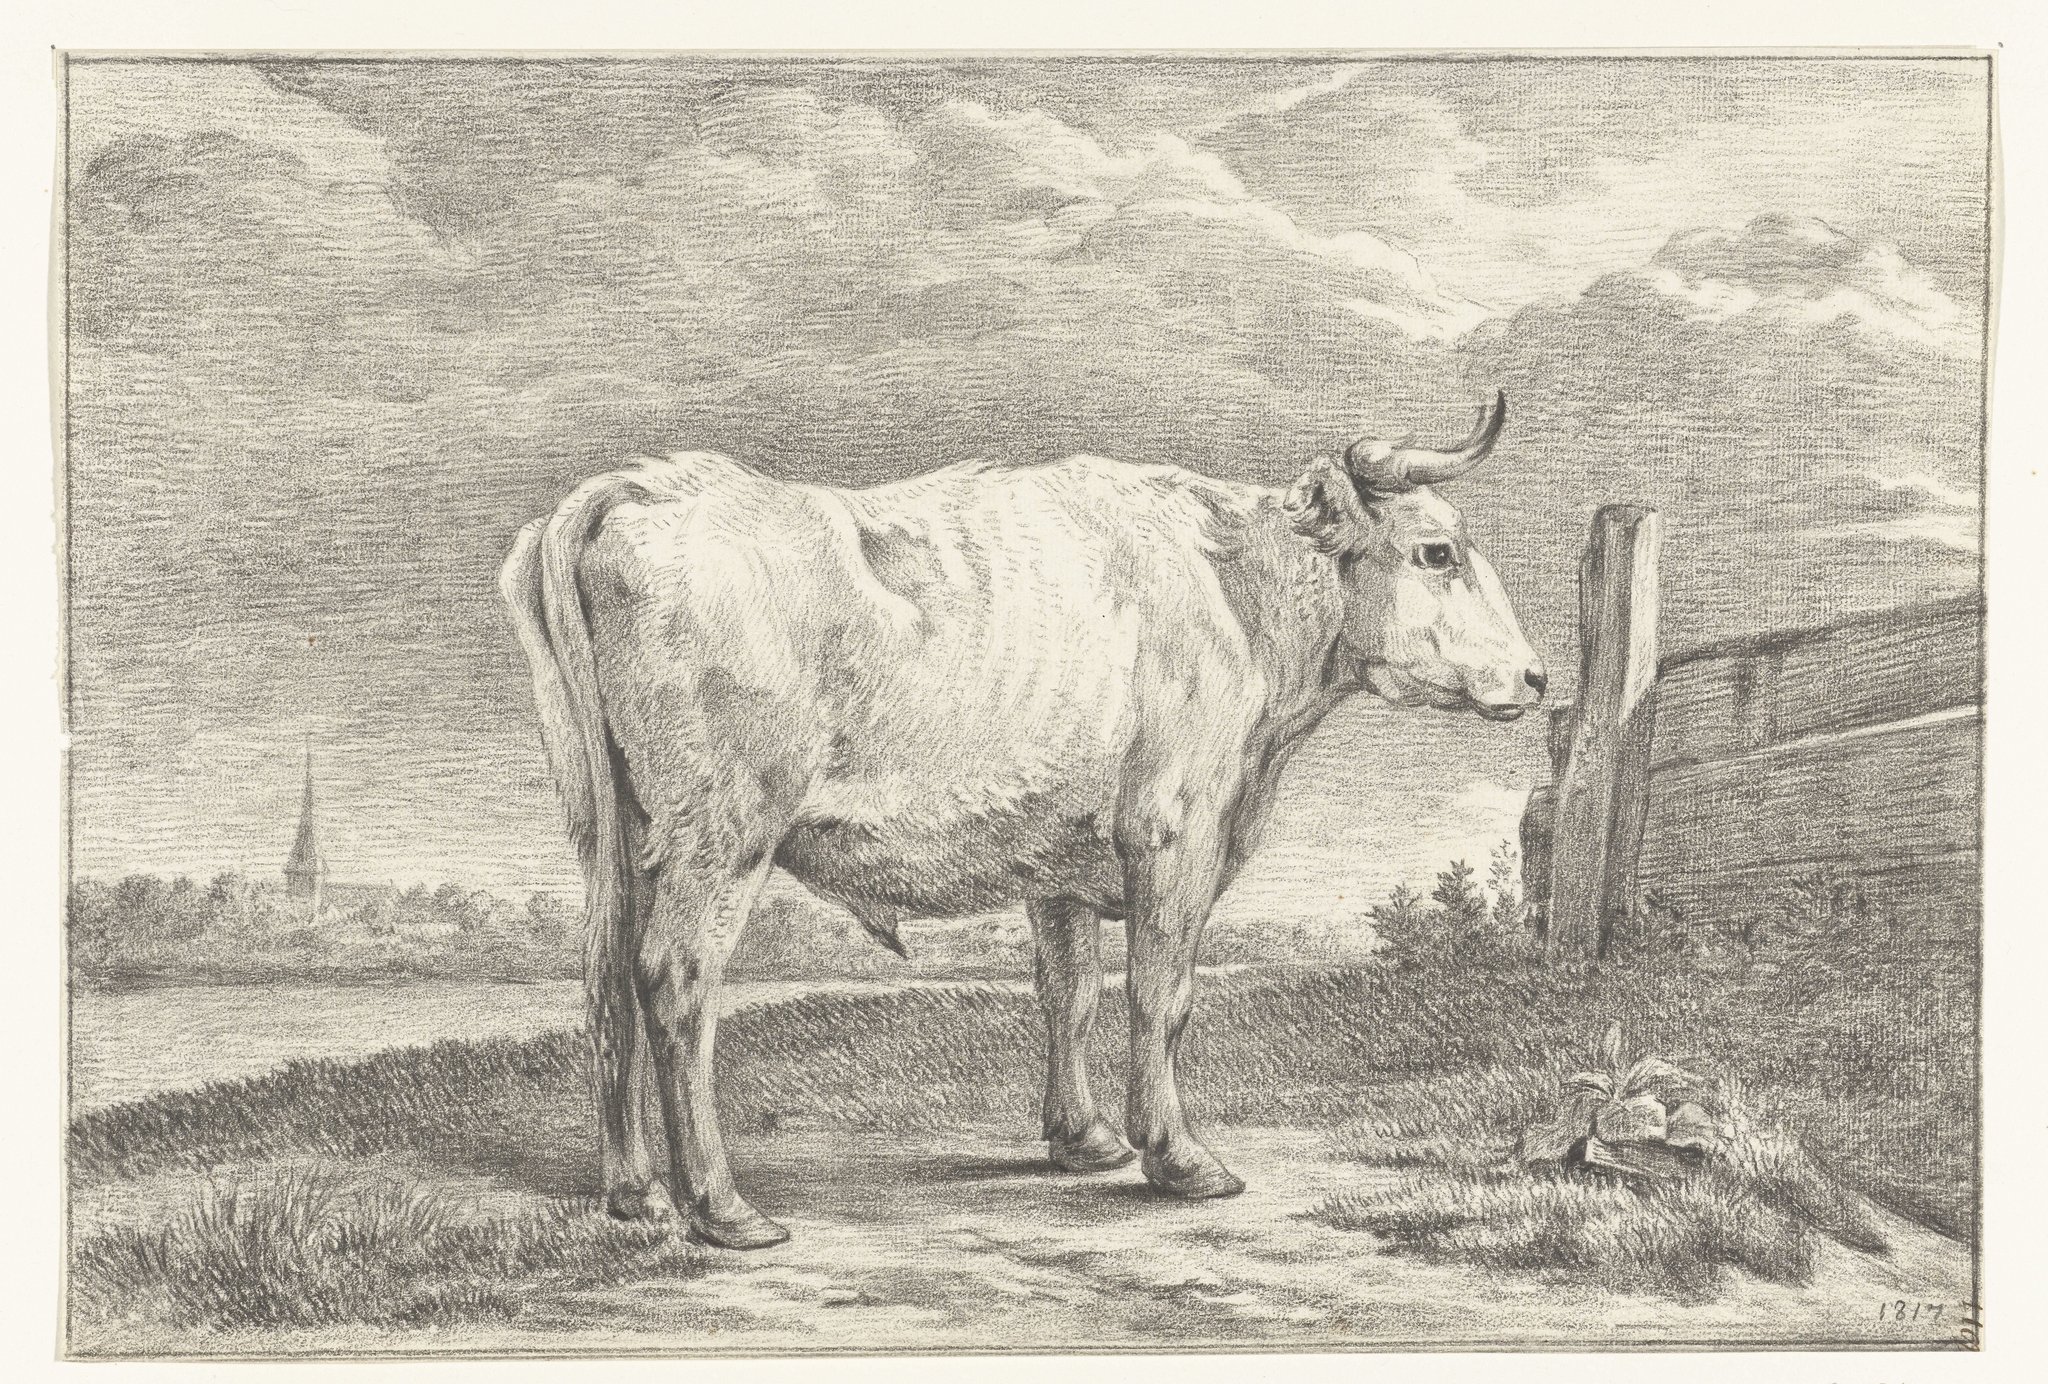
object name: drawing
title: Staande stier, naar rechts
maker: jean bernard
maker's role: draughtsman, print maker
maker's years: 1765-1833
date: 1817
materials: chalk, paper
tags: bull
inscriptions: date: ‘1817’